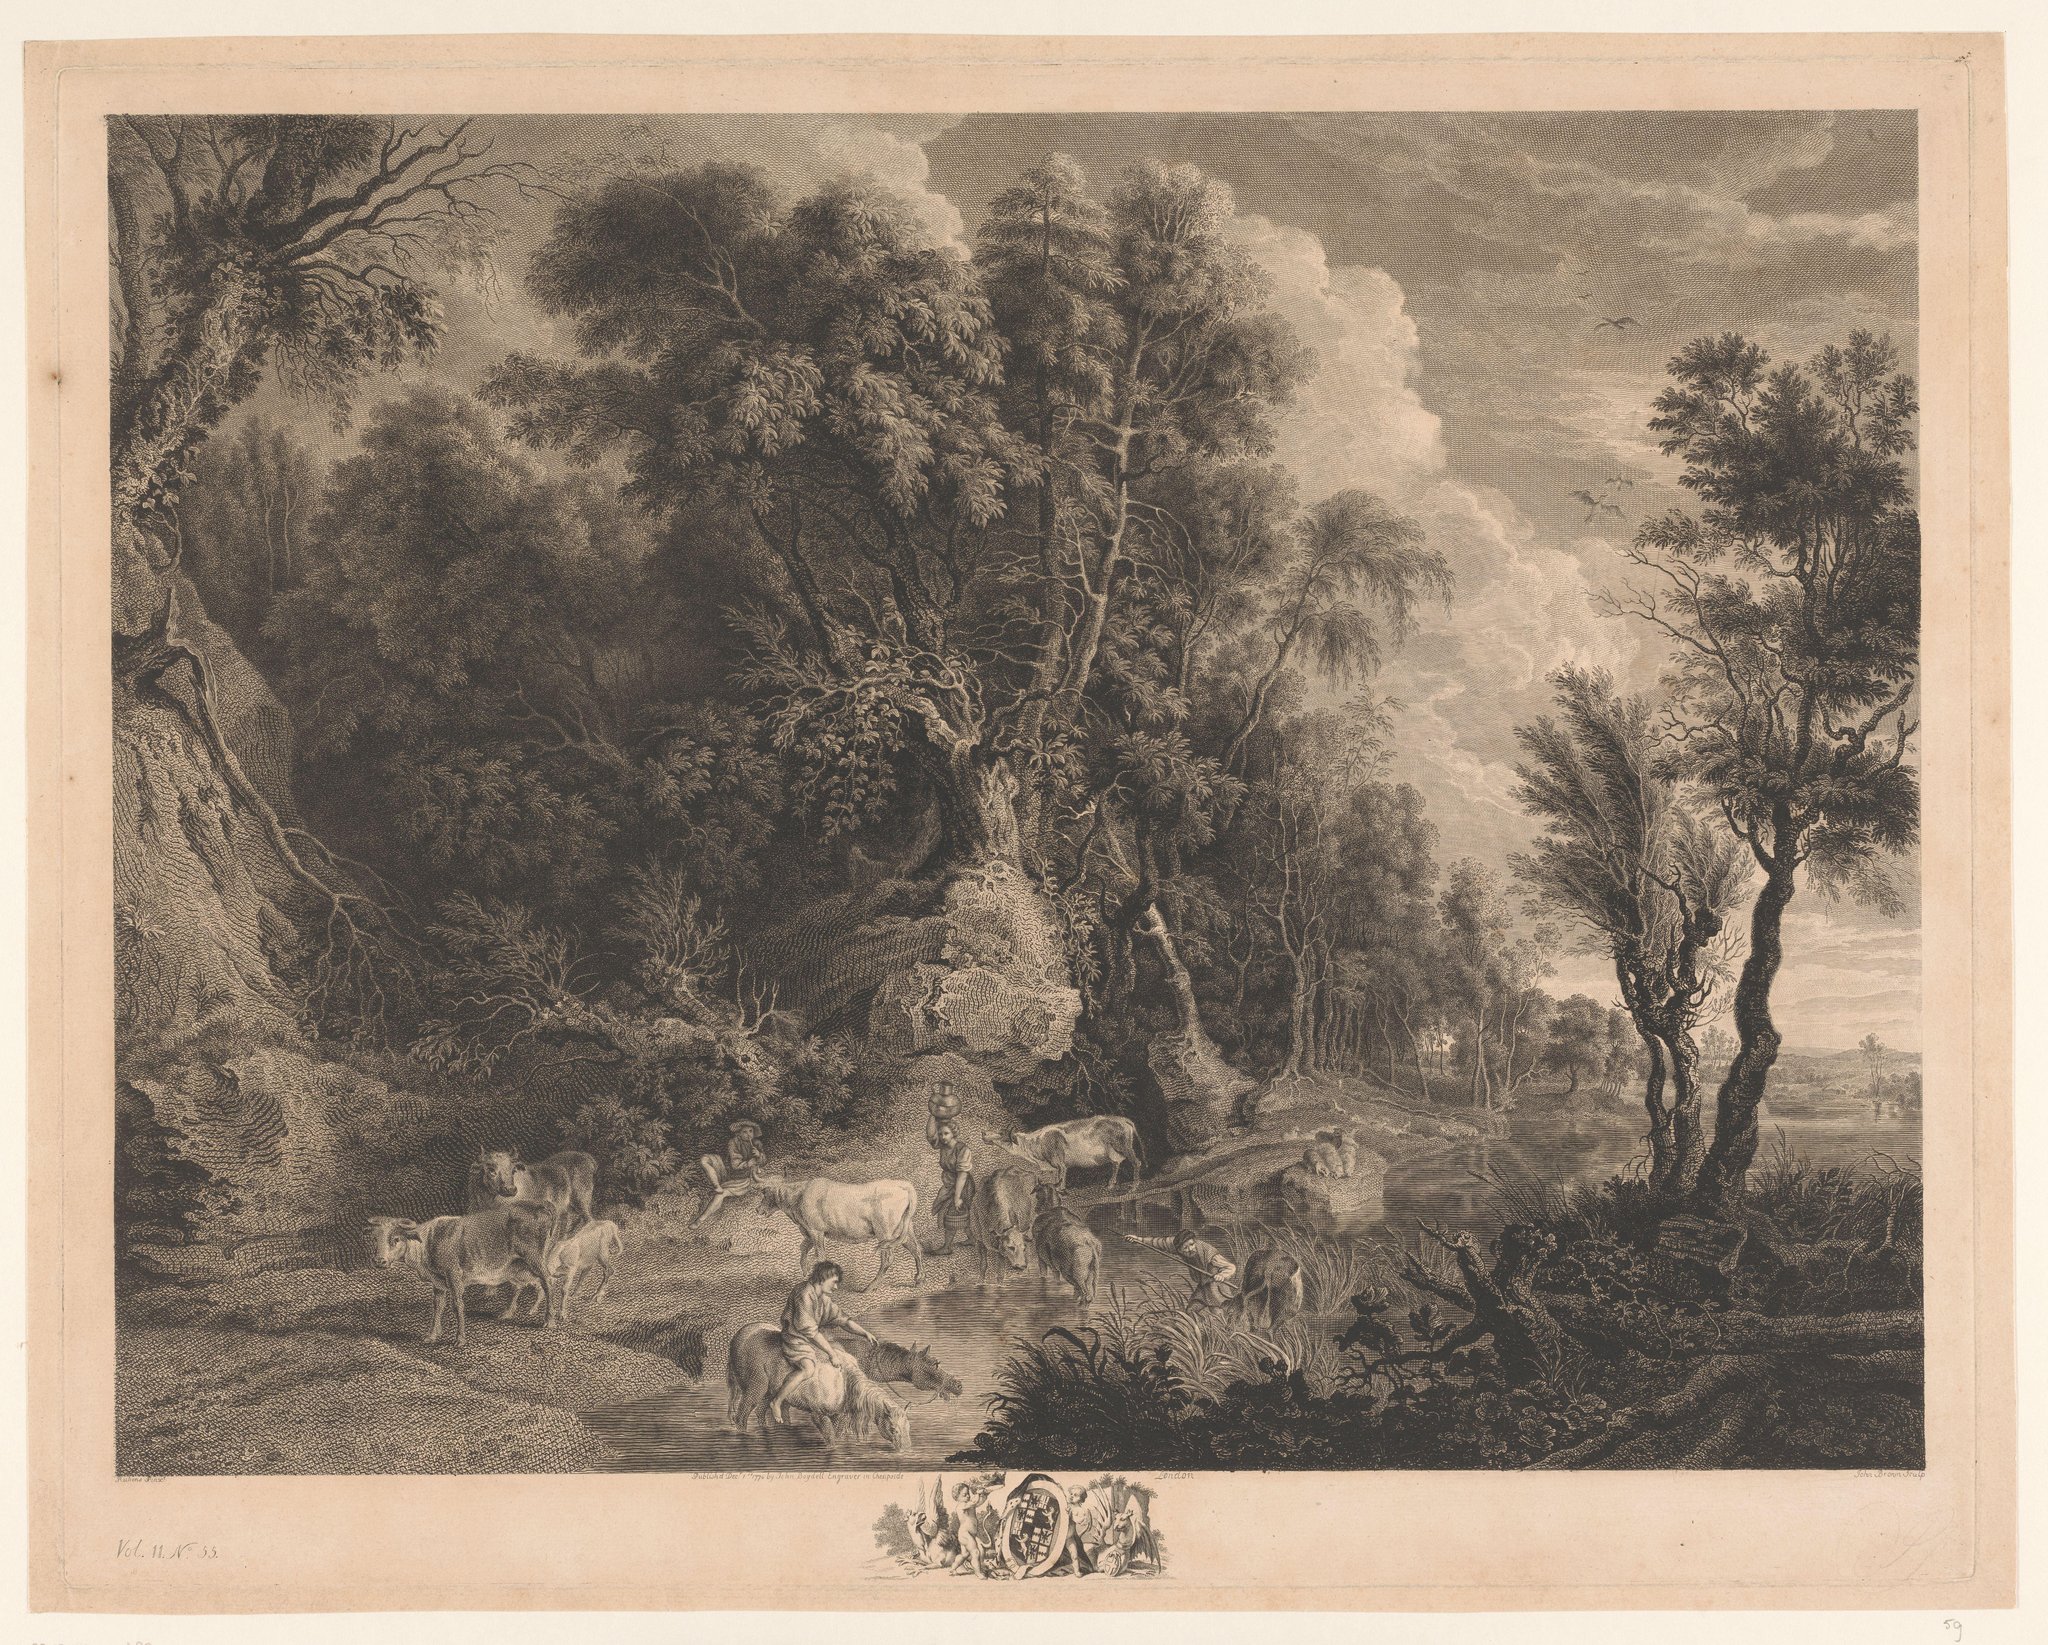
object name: print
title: The watering place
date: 1770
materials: paper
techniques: engraving, etching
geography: london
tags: herding, herdsman, herdswoman, shepherd, shepherdess, cowherd, etc., cattle, river (+ landscape with figures, staffage)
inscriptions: collector's mark: Lugt 12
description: Prent hoort mogelijk bij de serie 'The Most Capital Paintings in England', tussen 1763 en 1786 gepubliceerd door John Boydell.